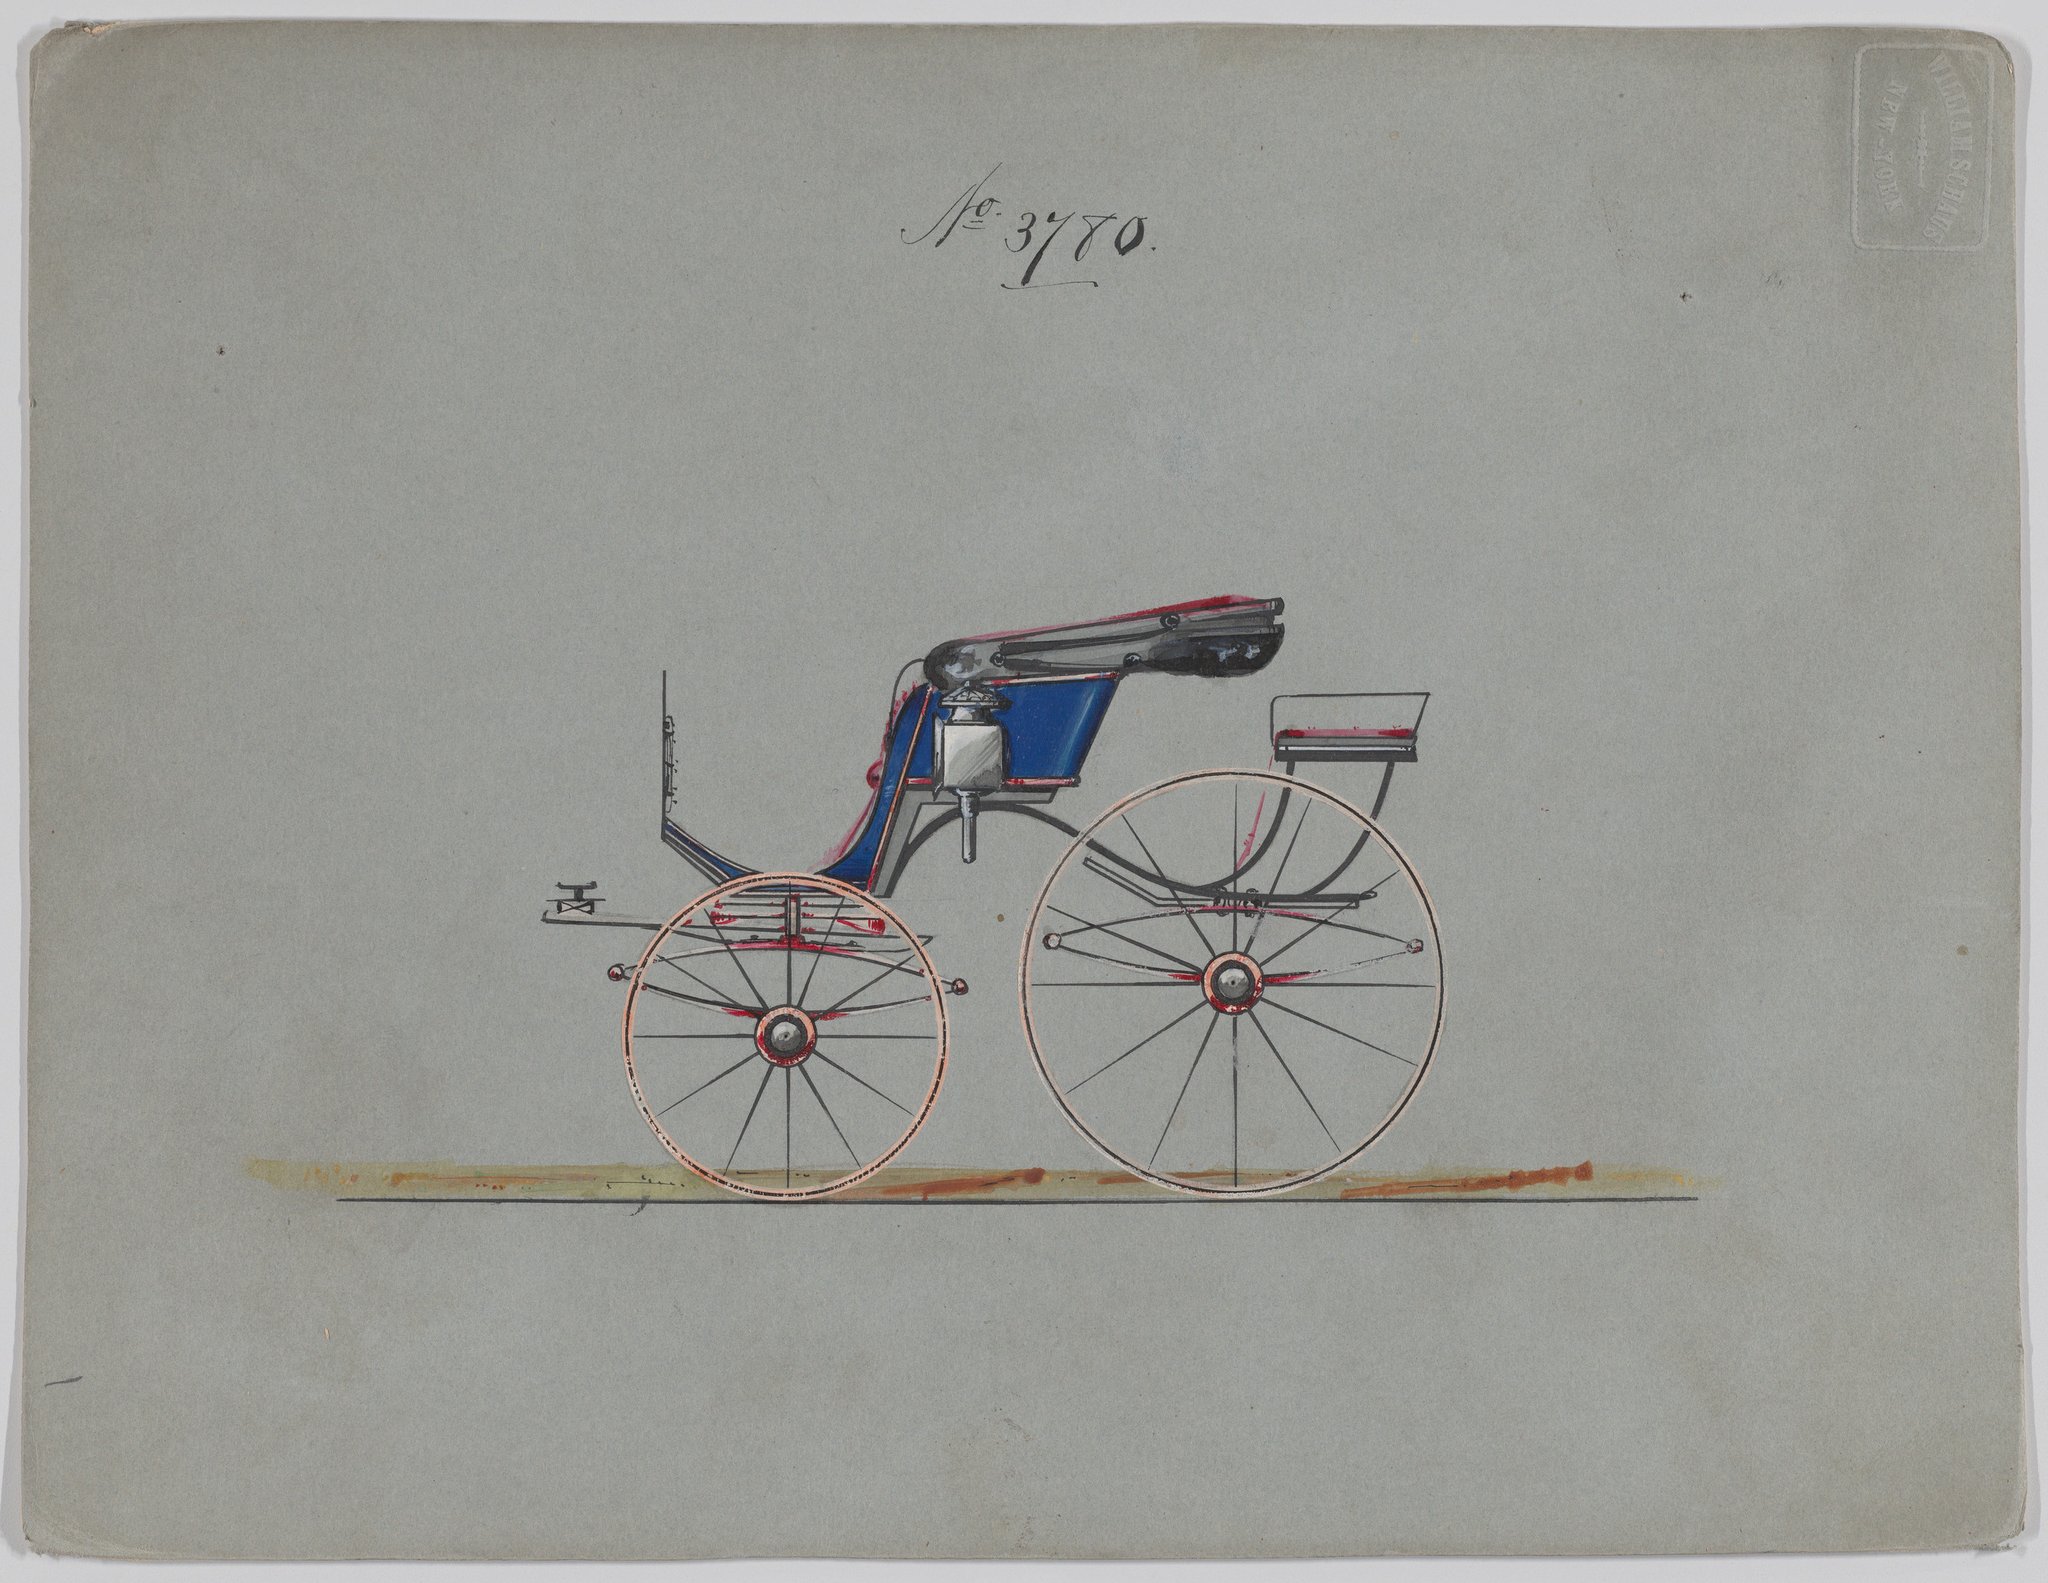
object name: drawing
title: Design for Pony Phaeton, no. 3780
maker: brewster & co.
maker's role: manufacturer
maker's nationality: american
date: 1882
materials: gouache, gum arabic, ink, watercolor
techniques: pen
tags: carriages